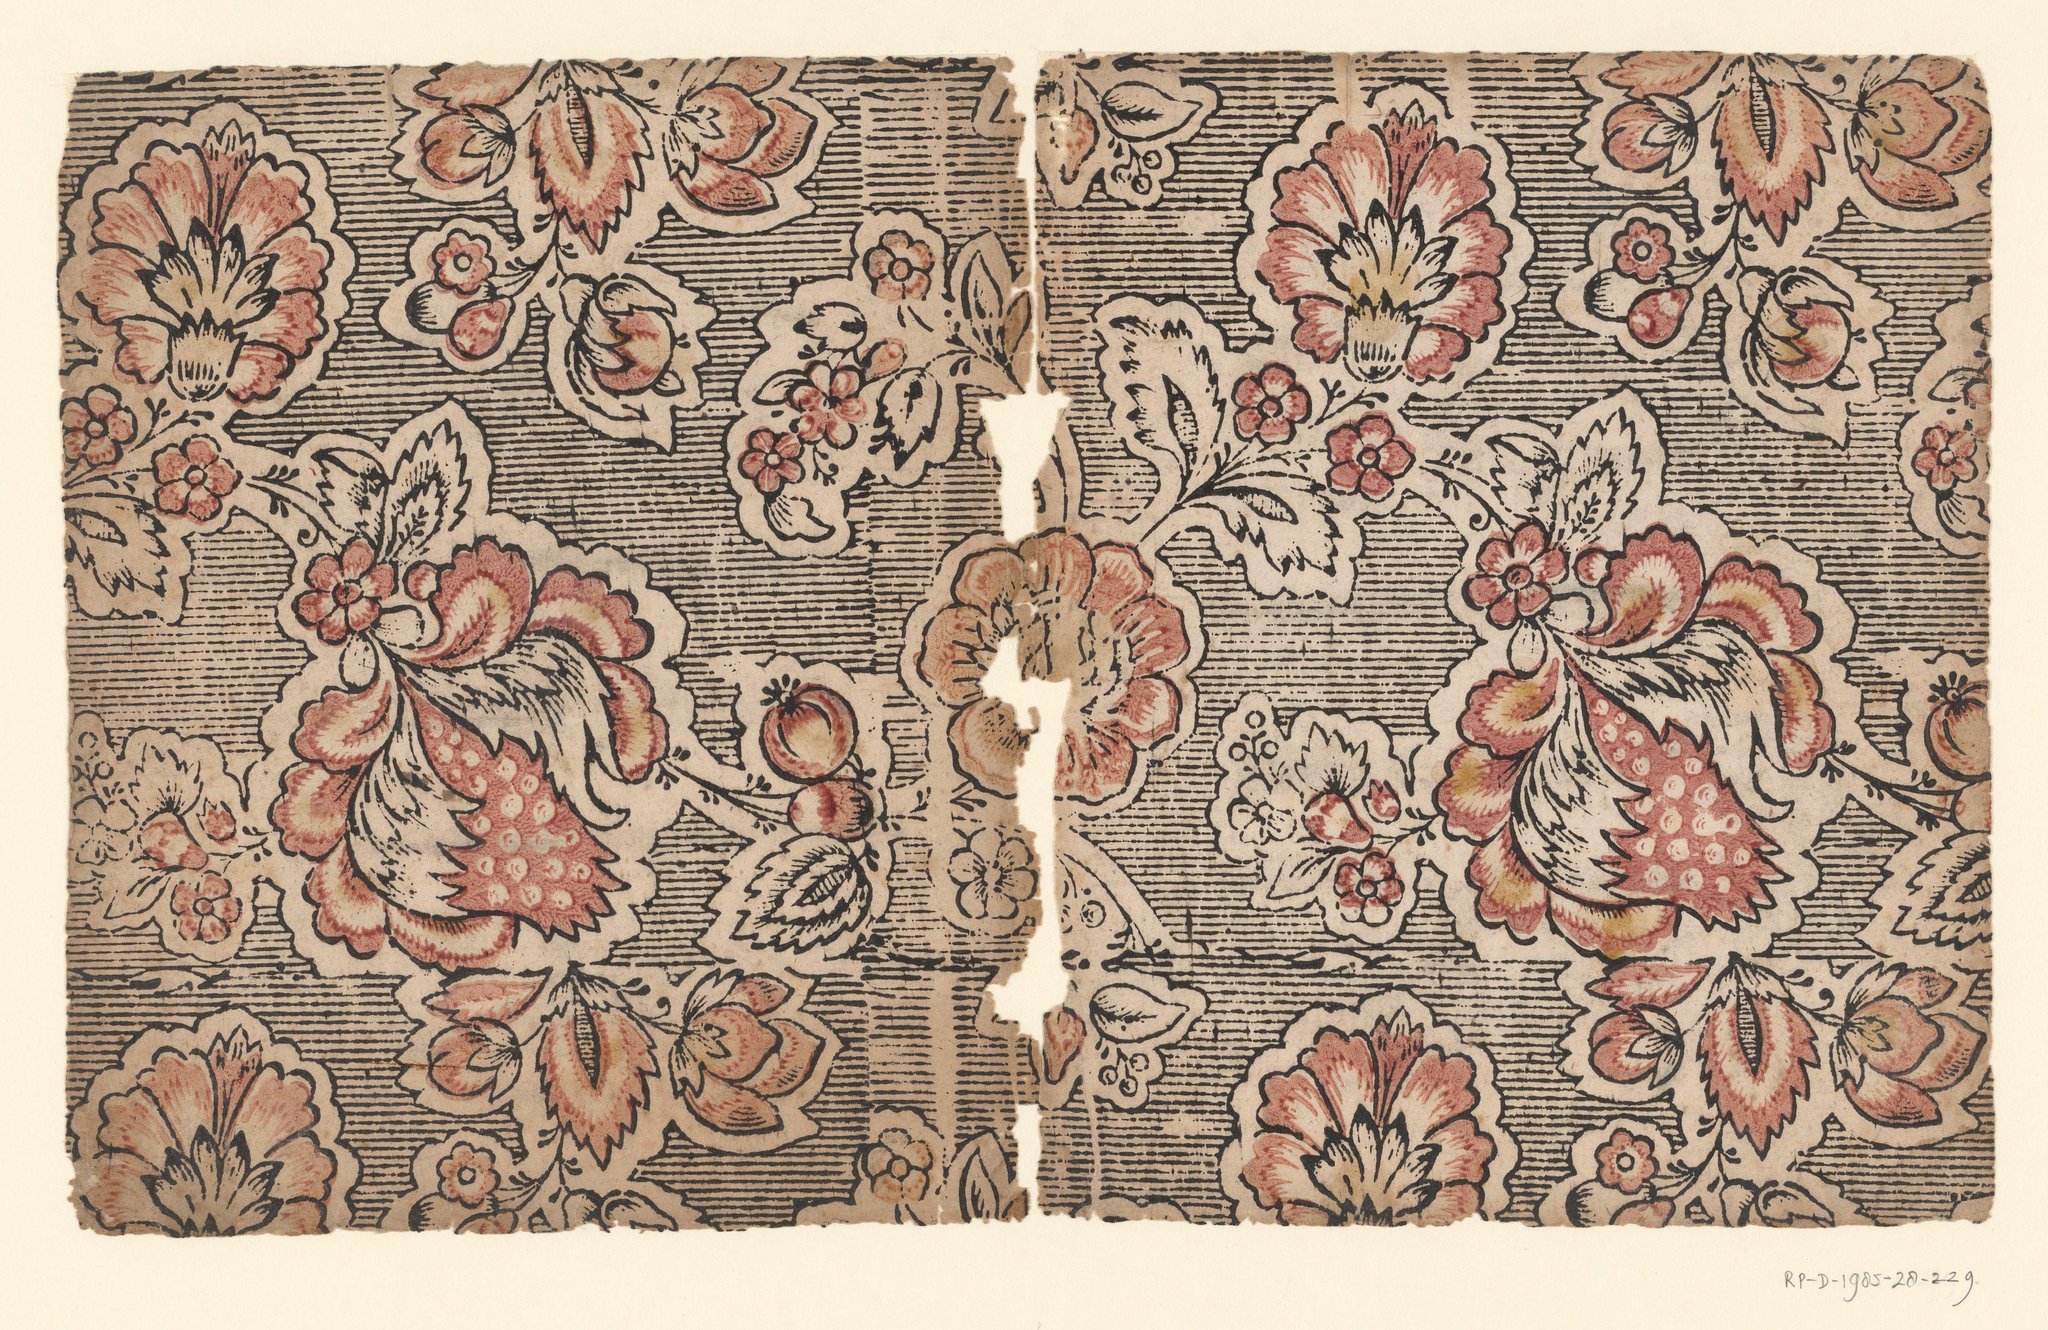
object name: printed paper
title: Twee bladen met strooipatroon van bloemen en vruchten met een onderbroken lijnenfond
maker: Anonymous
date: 1750-1900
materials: paper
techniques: printing block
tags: ornament derived from plant forms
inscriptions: collector's mark: Lugt 2228, collector's mark: Lugt 2760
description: Twee bladen met strooipatroon van bloemen en vruchten met een onderbroken lijnenfond. Twee losse helften van een omslag.